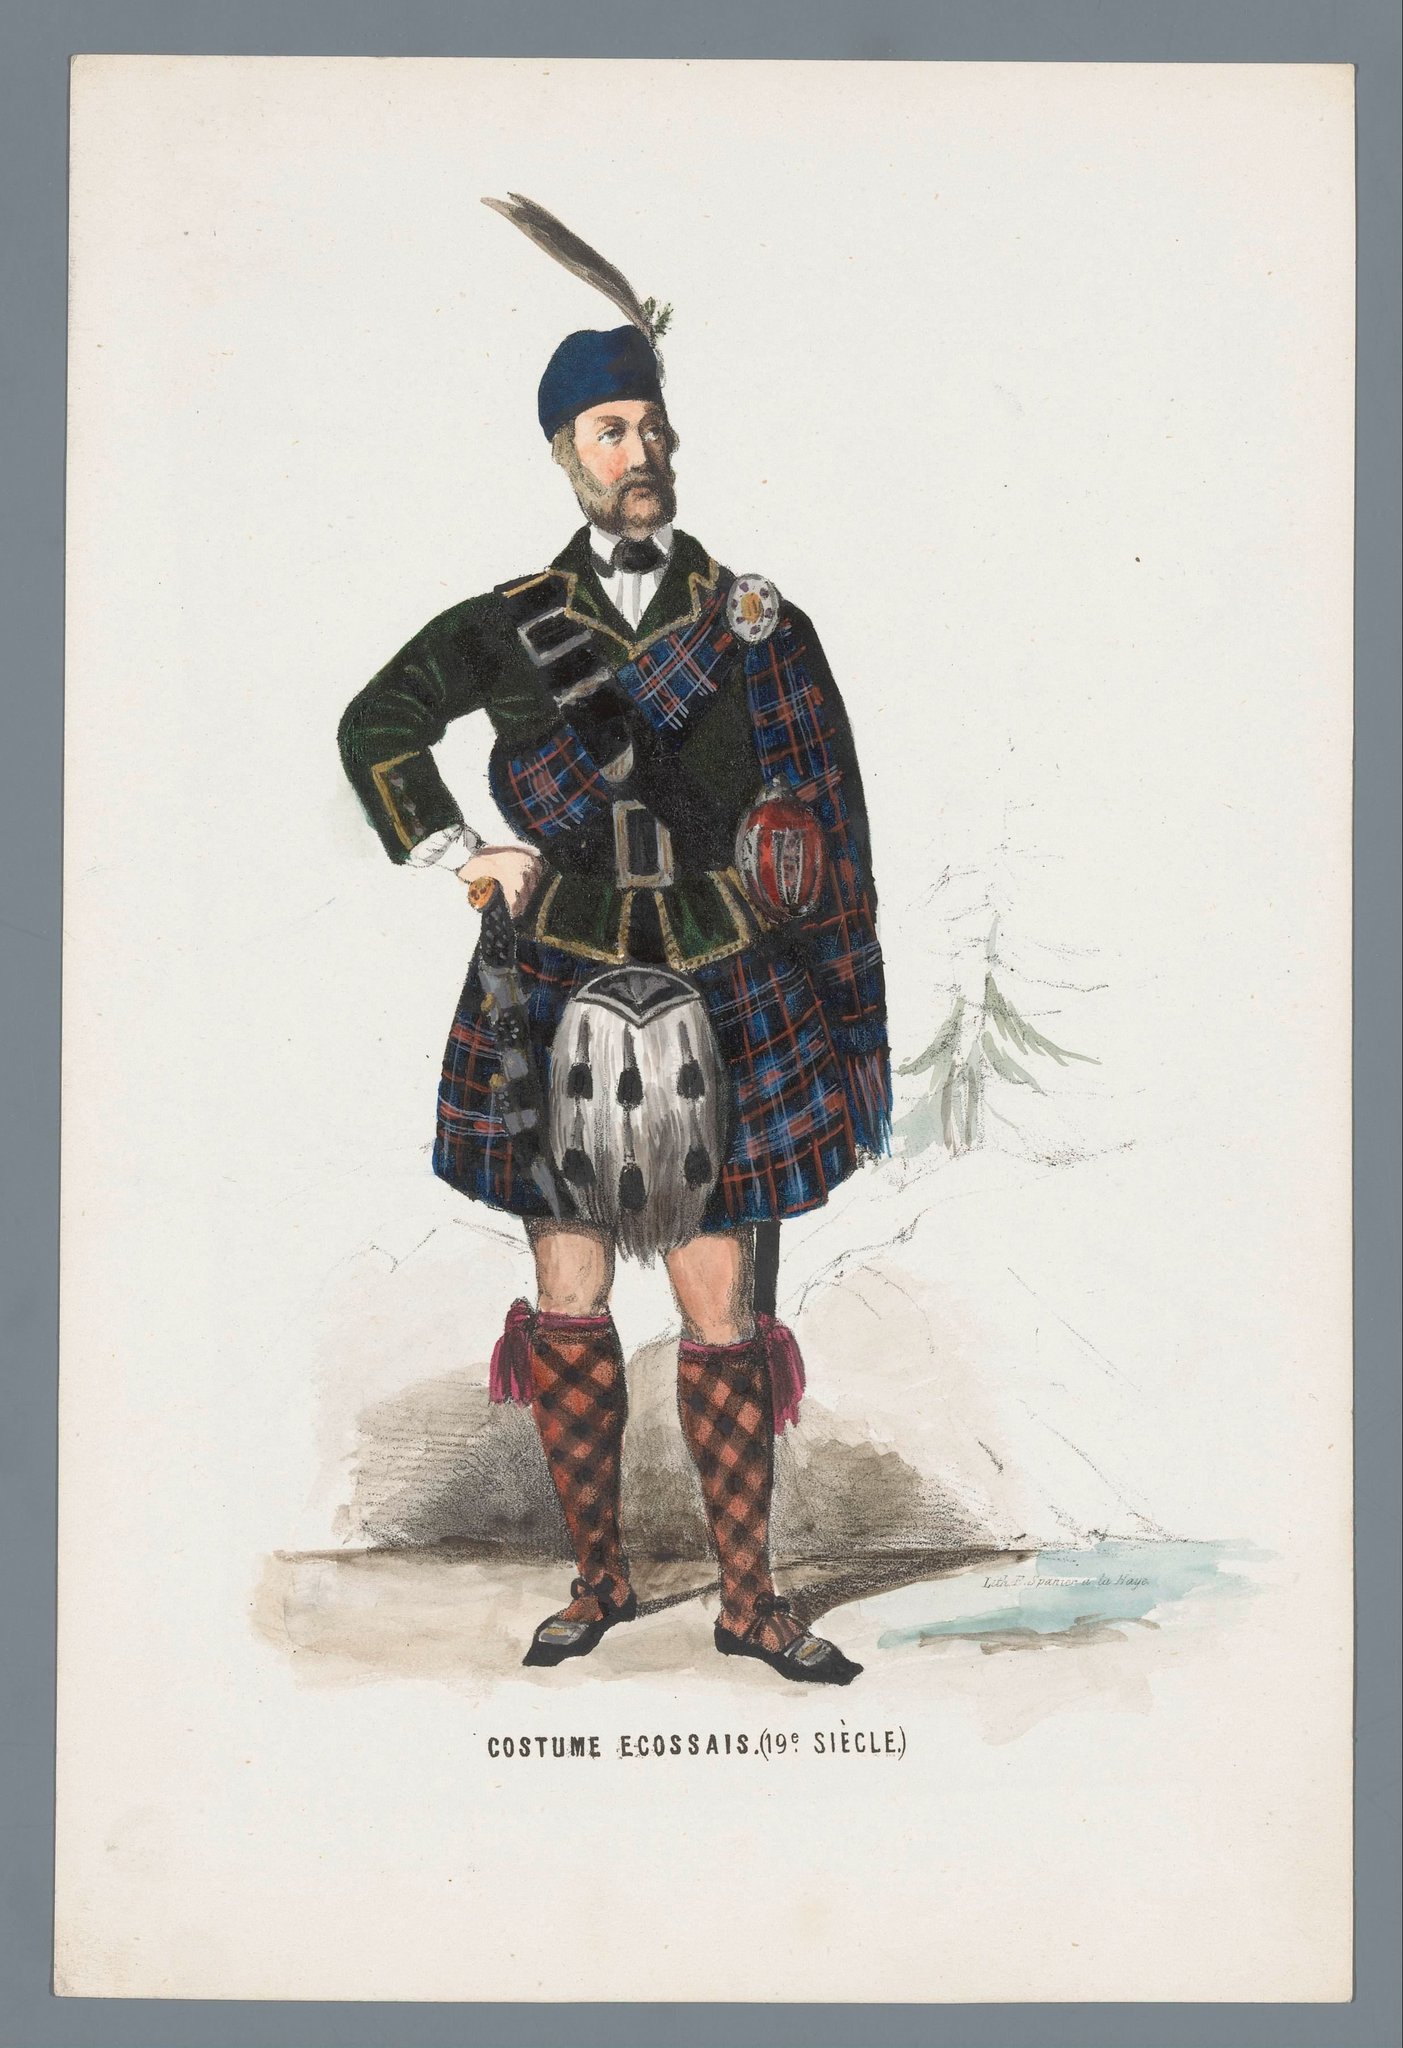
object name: costume print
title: Costume Ecossais. (19e Siècle.)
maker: elias spanier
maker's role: print maker, printer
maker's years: 1821-1863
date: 1840-1850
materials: paper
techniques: hand coloring, lithograph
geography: the hague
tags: historical costume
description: Man in Schots kostuum, 19e eeuw. Voorstelling toegevoegd aan het plaatwerk over het gekostumeerd bal gehouden op het paleis van de prins van Oranje (de latere koning Willem III) in Den Haag op 26 februari 1845.